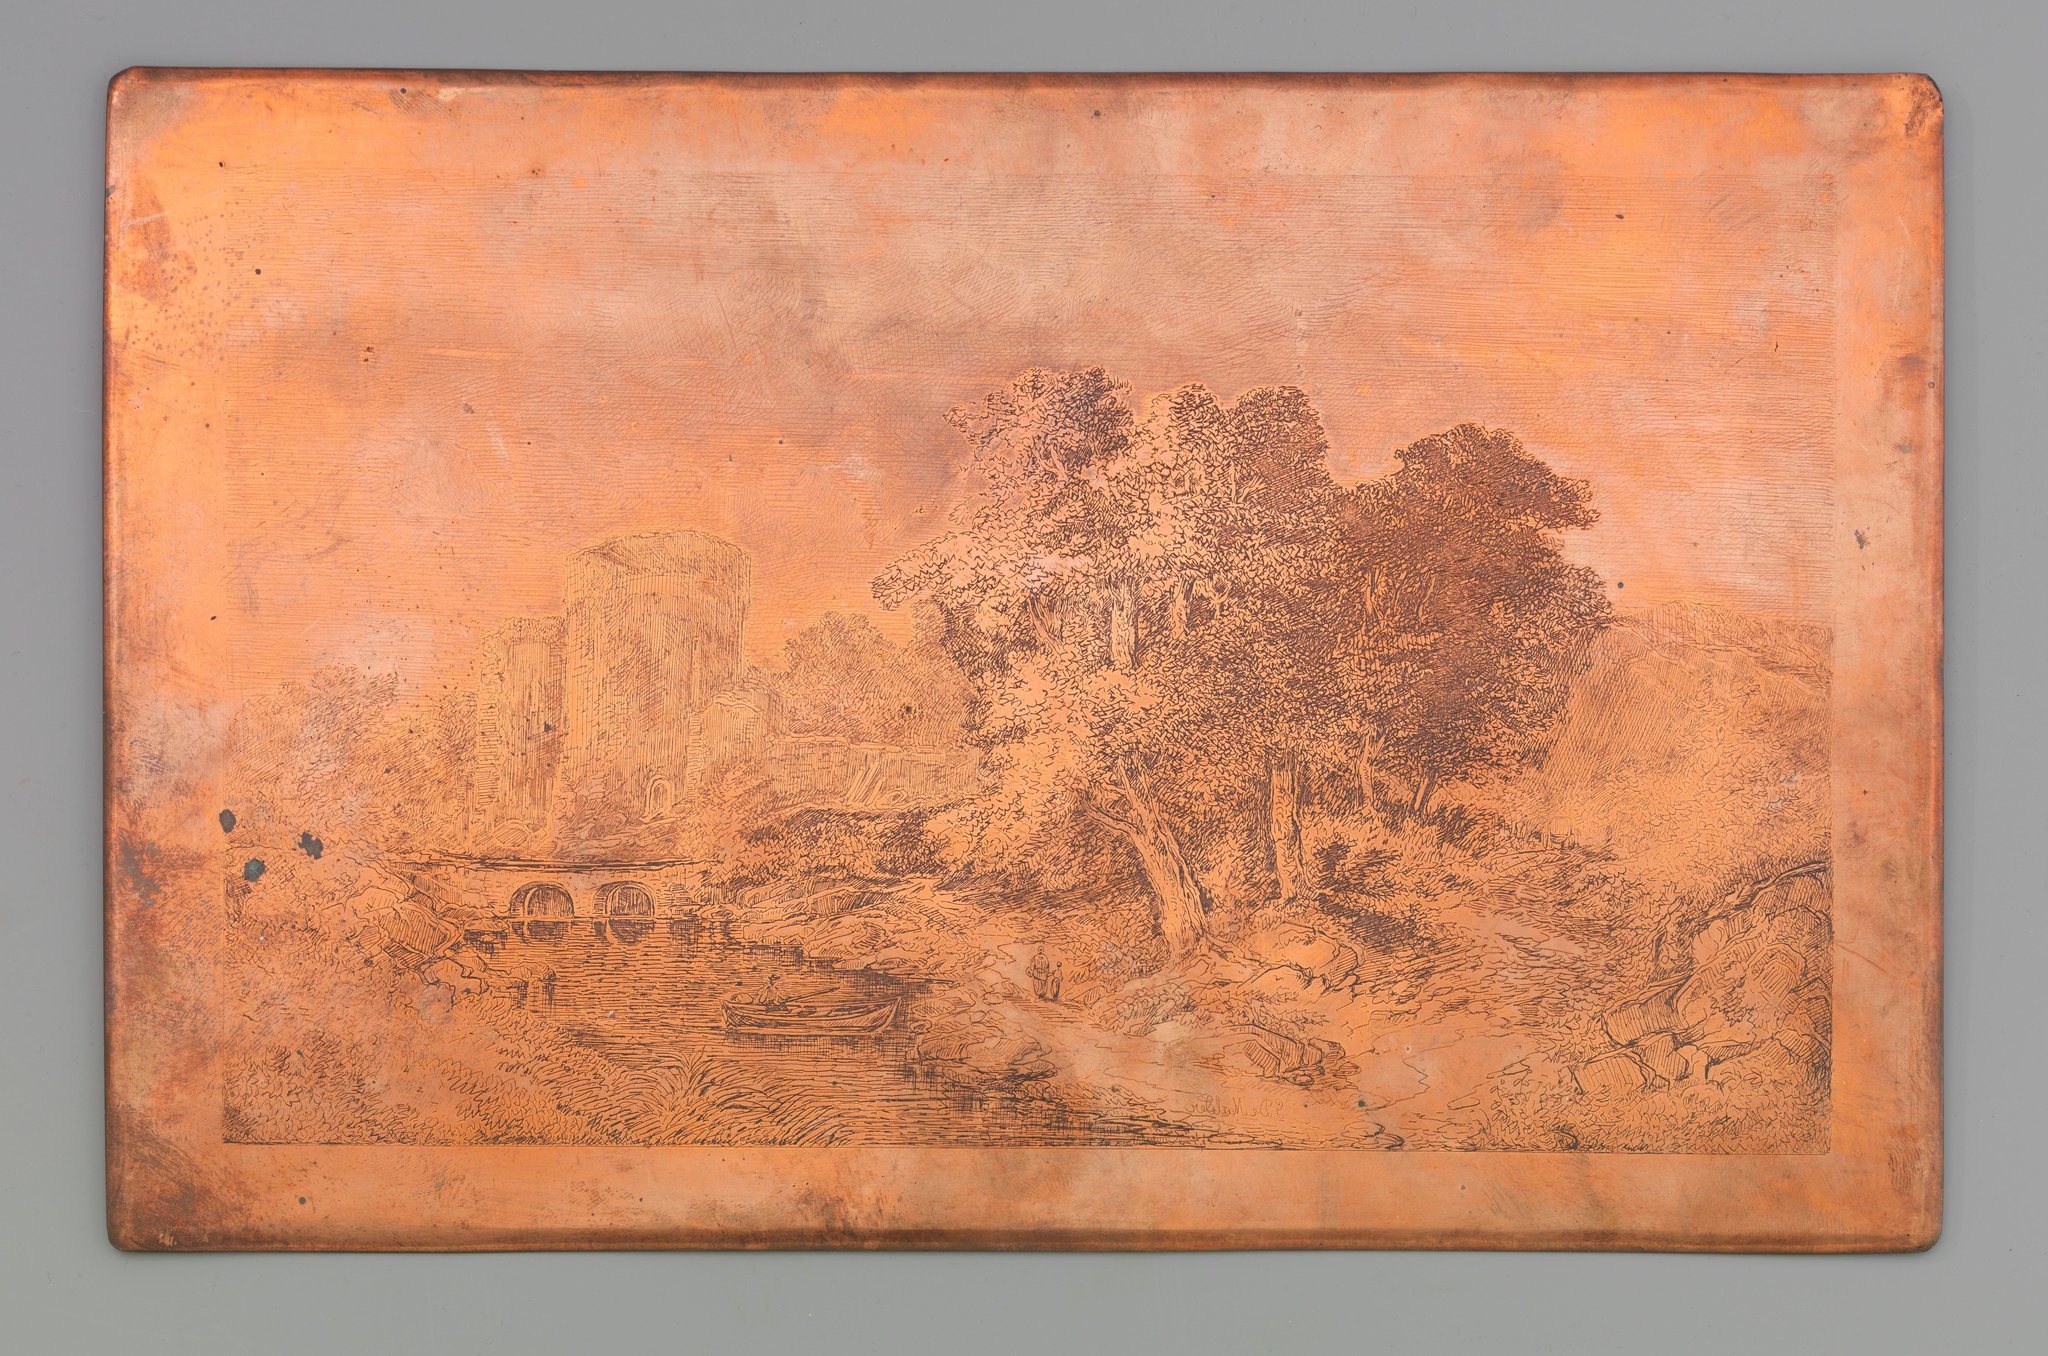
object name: copper plate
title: Landschap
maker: g. de mulder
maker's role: print maker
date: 1800-1899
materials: copper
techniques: etching